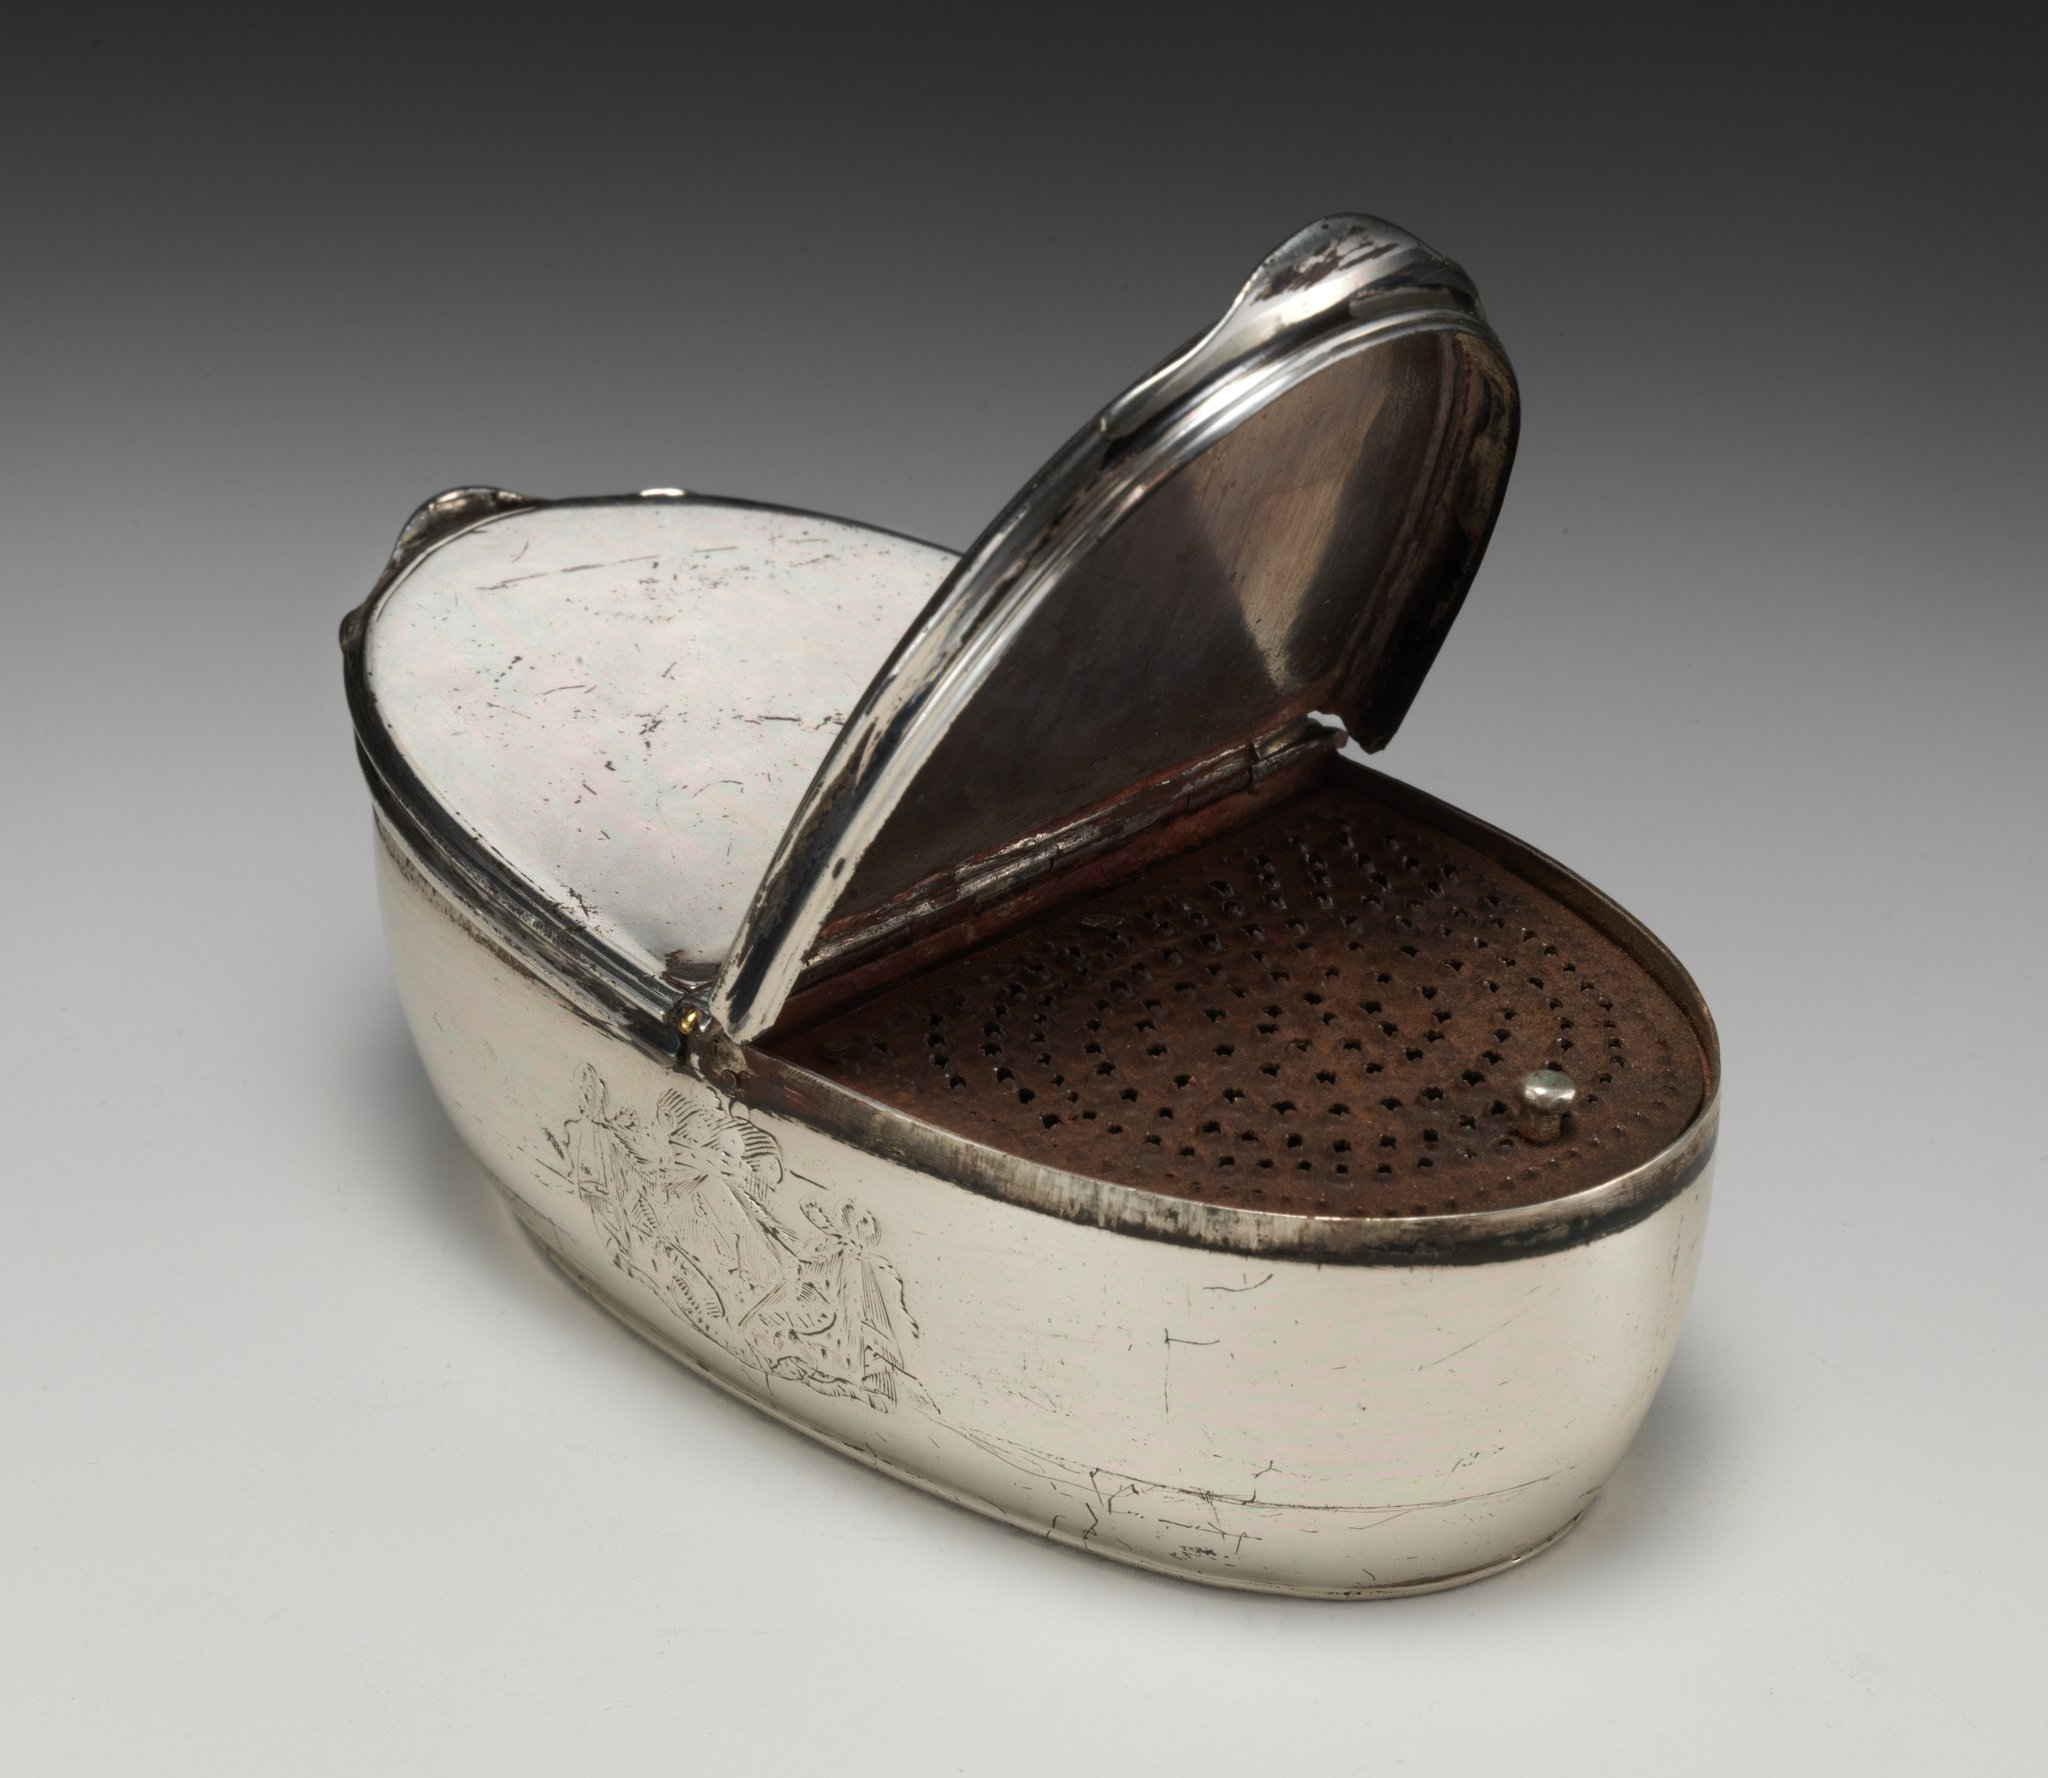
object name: nutmeg or spice box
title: Nutmeg or spice box with arms of Mary Lady Hervey of Ickworth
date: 1743-1768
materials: silver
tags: coat of arms